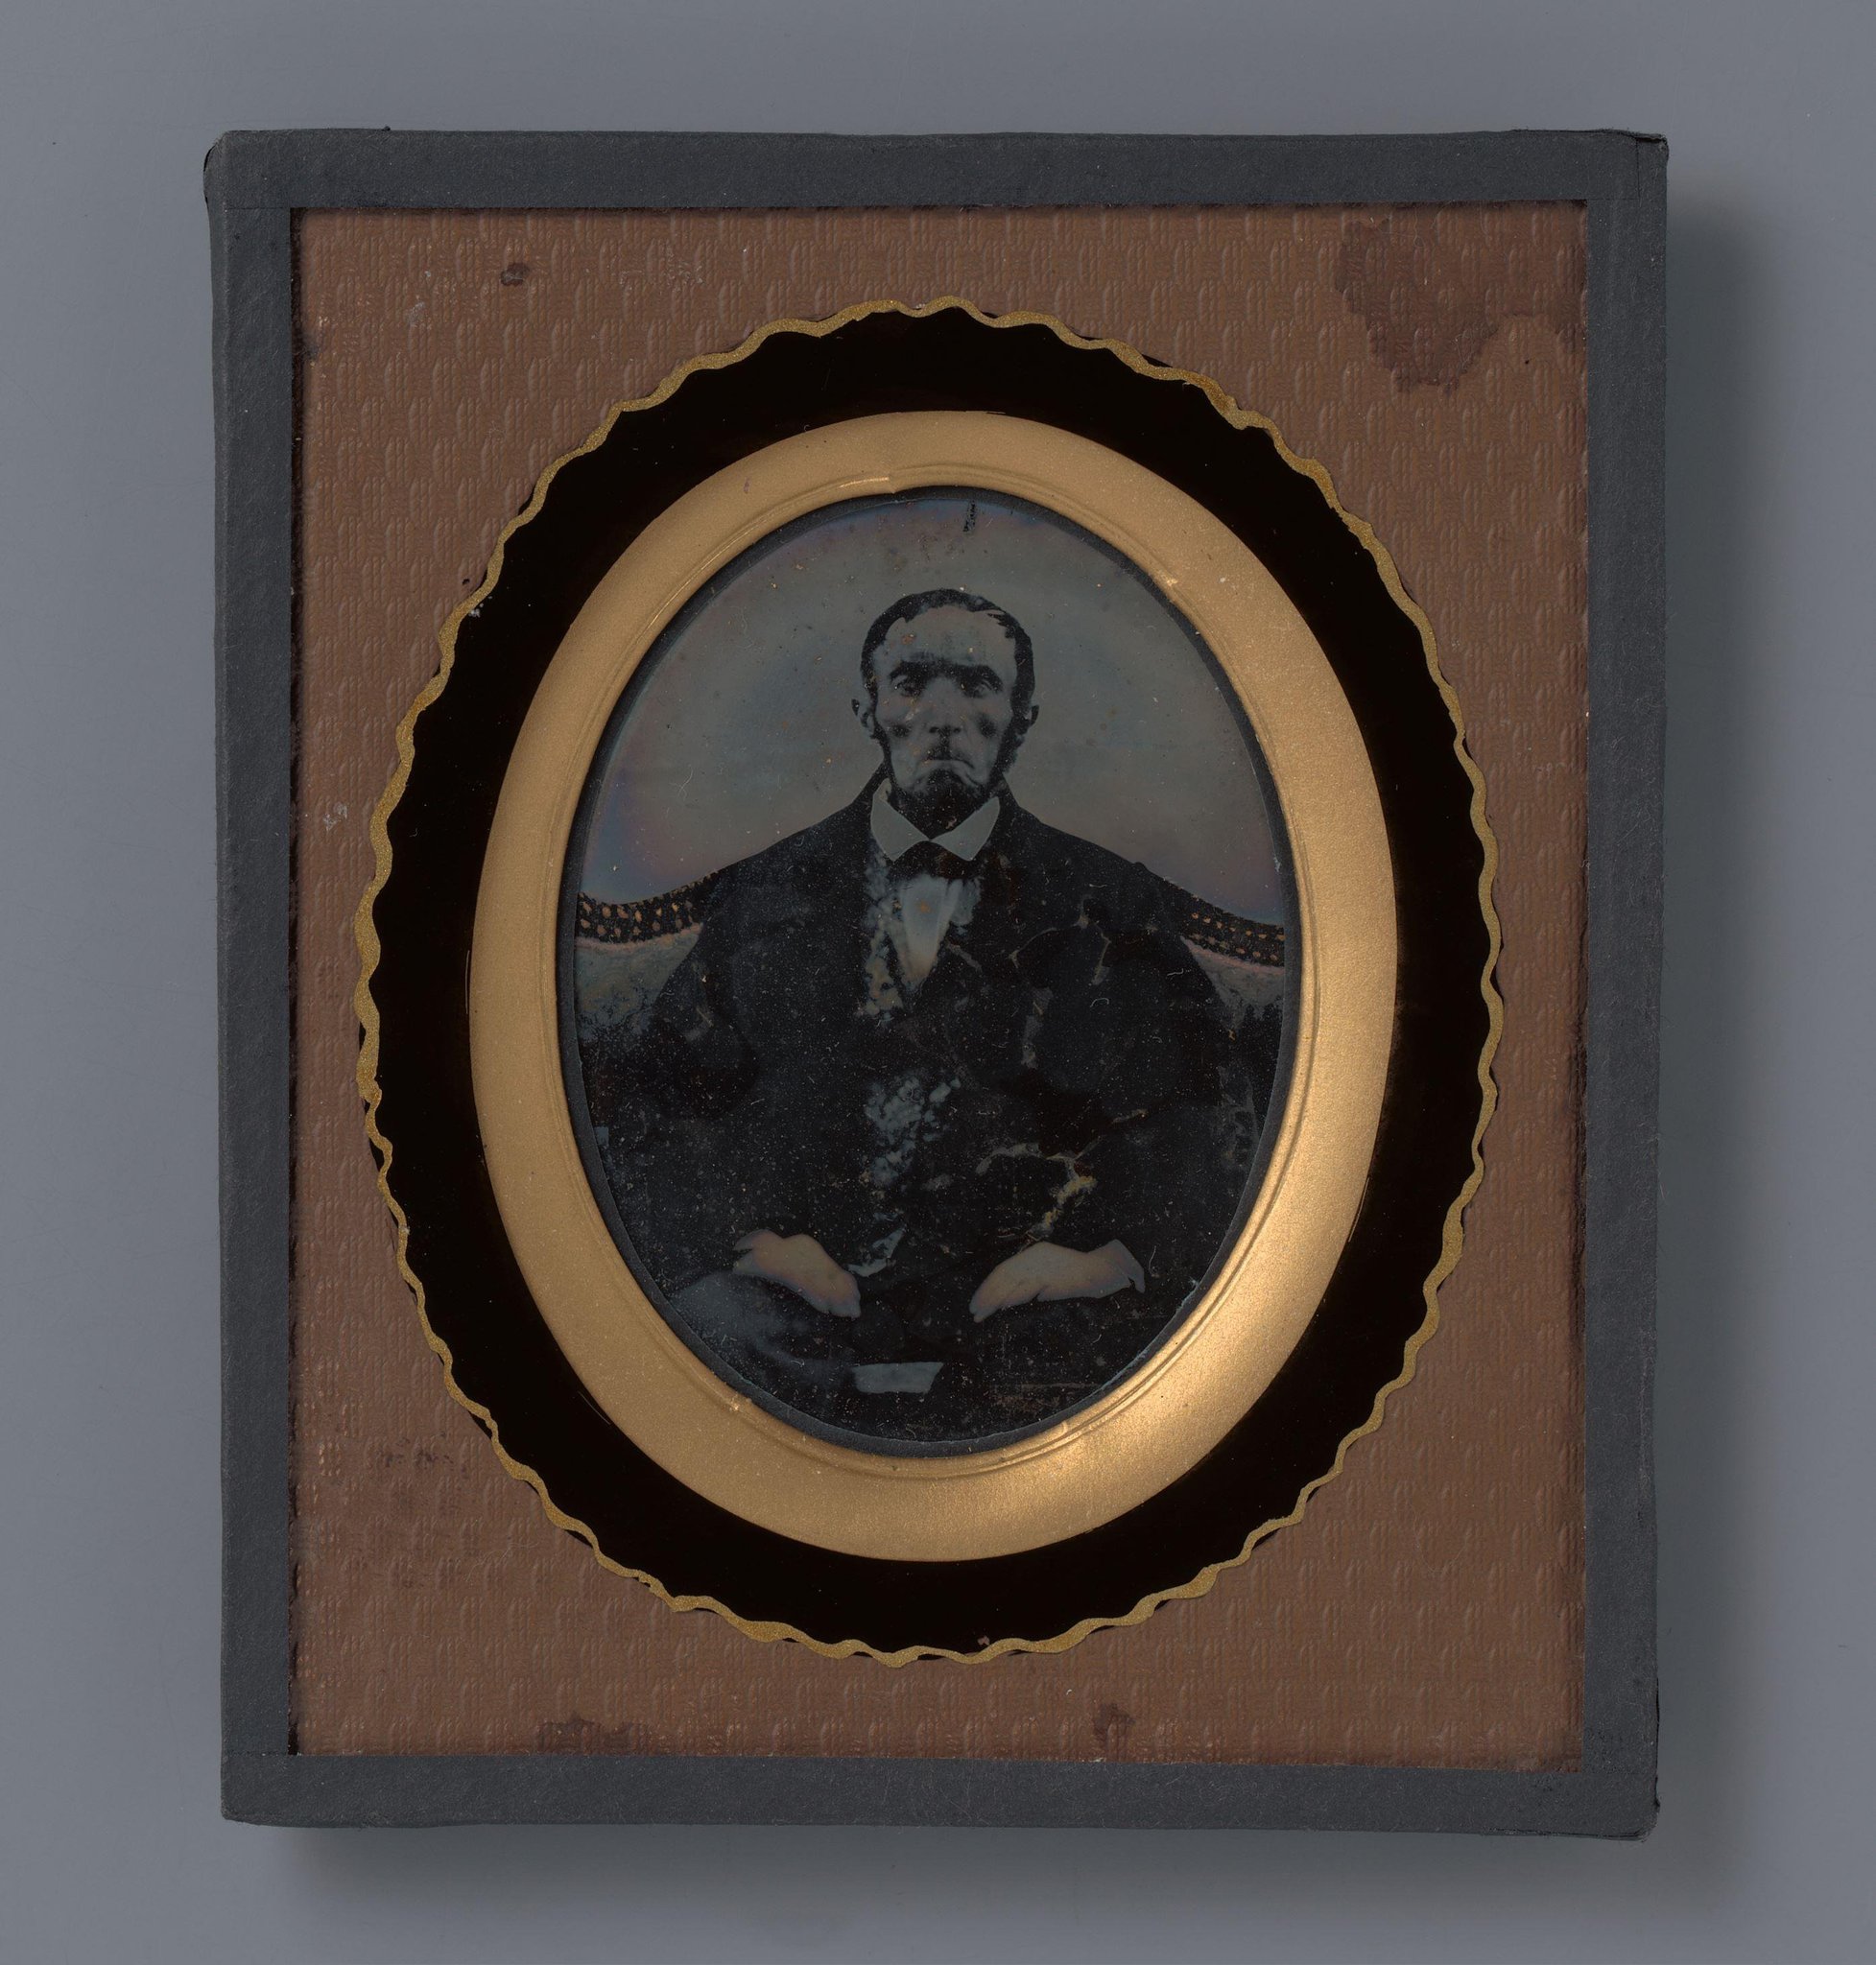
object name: photograph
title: Post-mortemportret van een man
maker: Anonymous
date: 1855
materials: glass, paper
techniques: ambrotype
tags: sitting figure, adult man, historical persons, the corpse